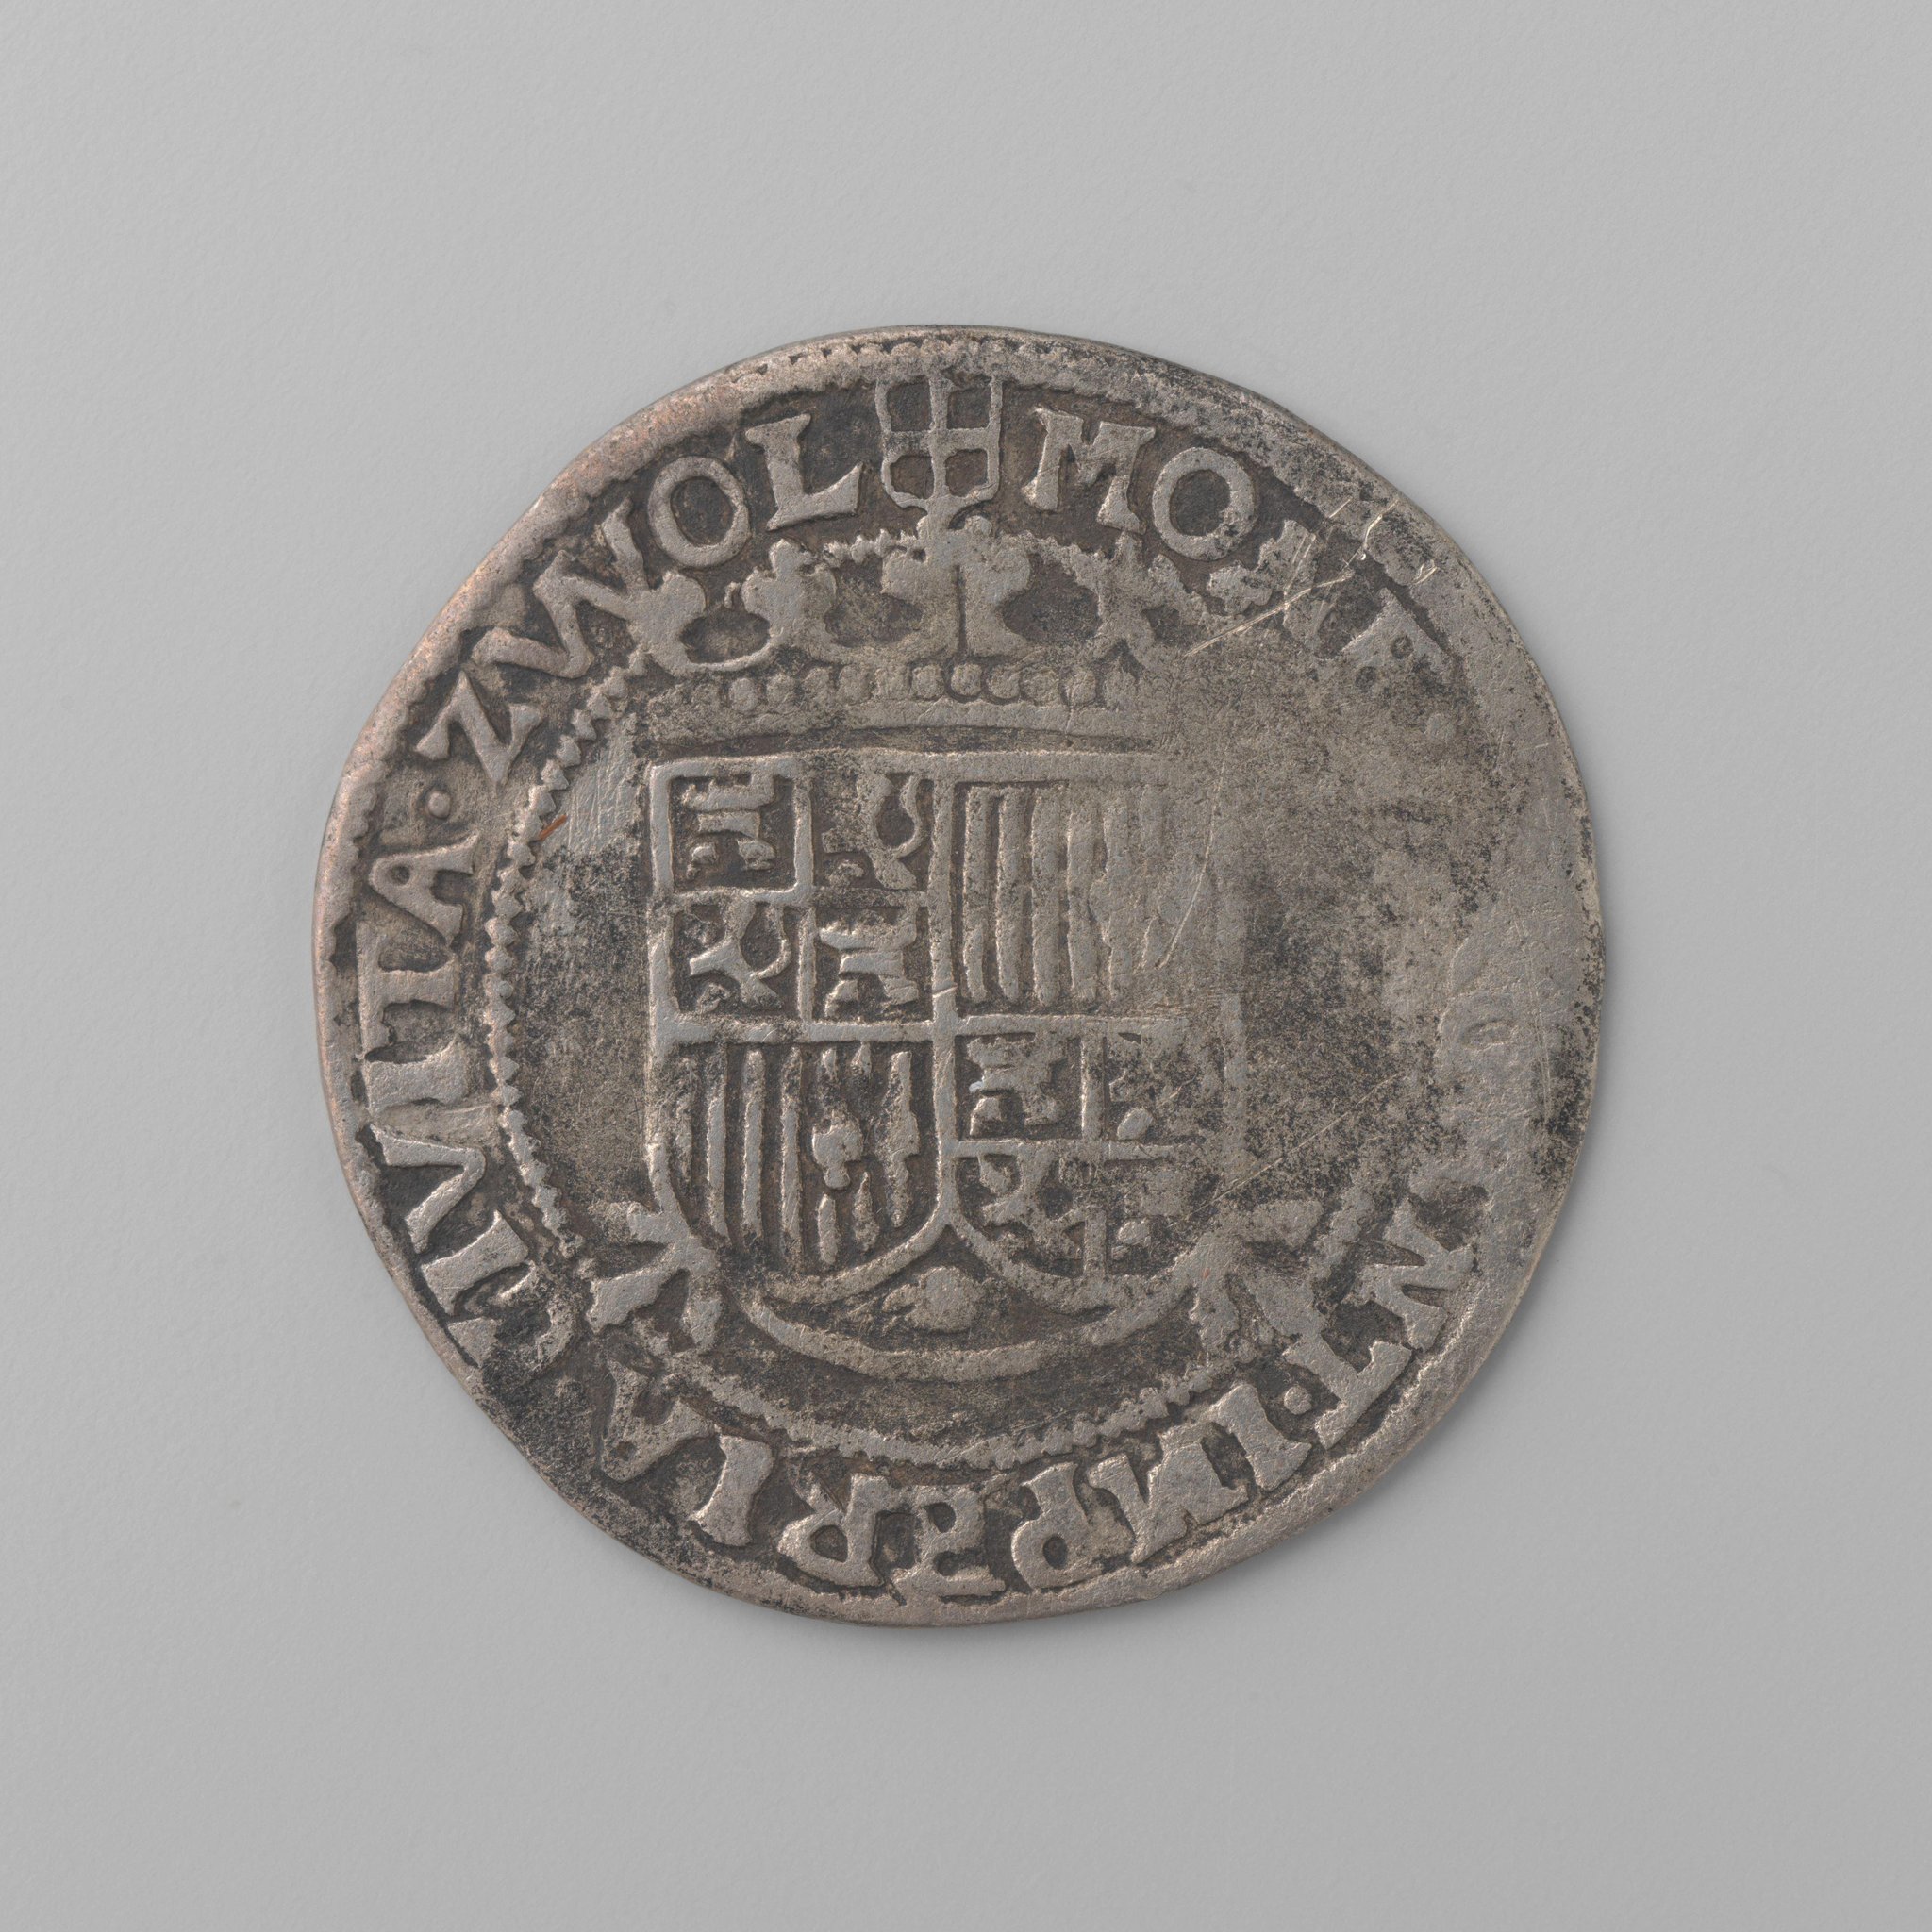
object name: coin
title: Zwolse arendschelling, op naam van Rudolf II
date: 1601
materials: silver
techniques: striking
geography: zwolle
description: Voorzijde: gekroond gevierendeeld wapenschild. Keerzijde: gekroonde dubbelkoppige adelaar met rijksappel.